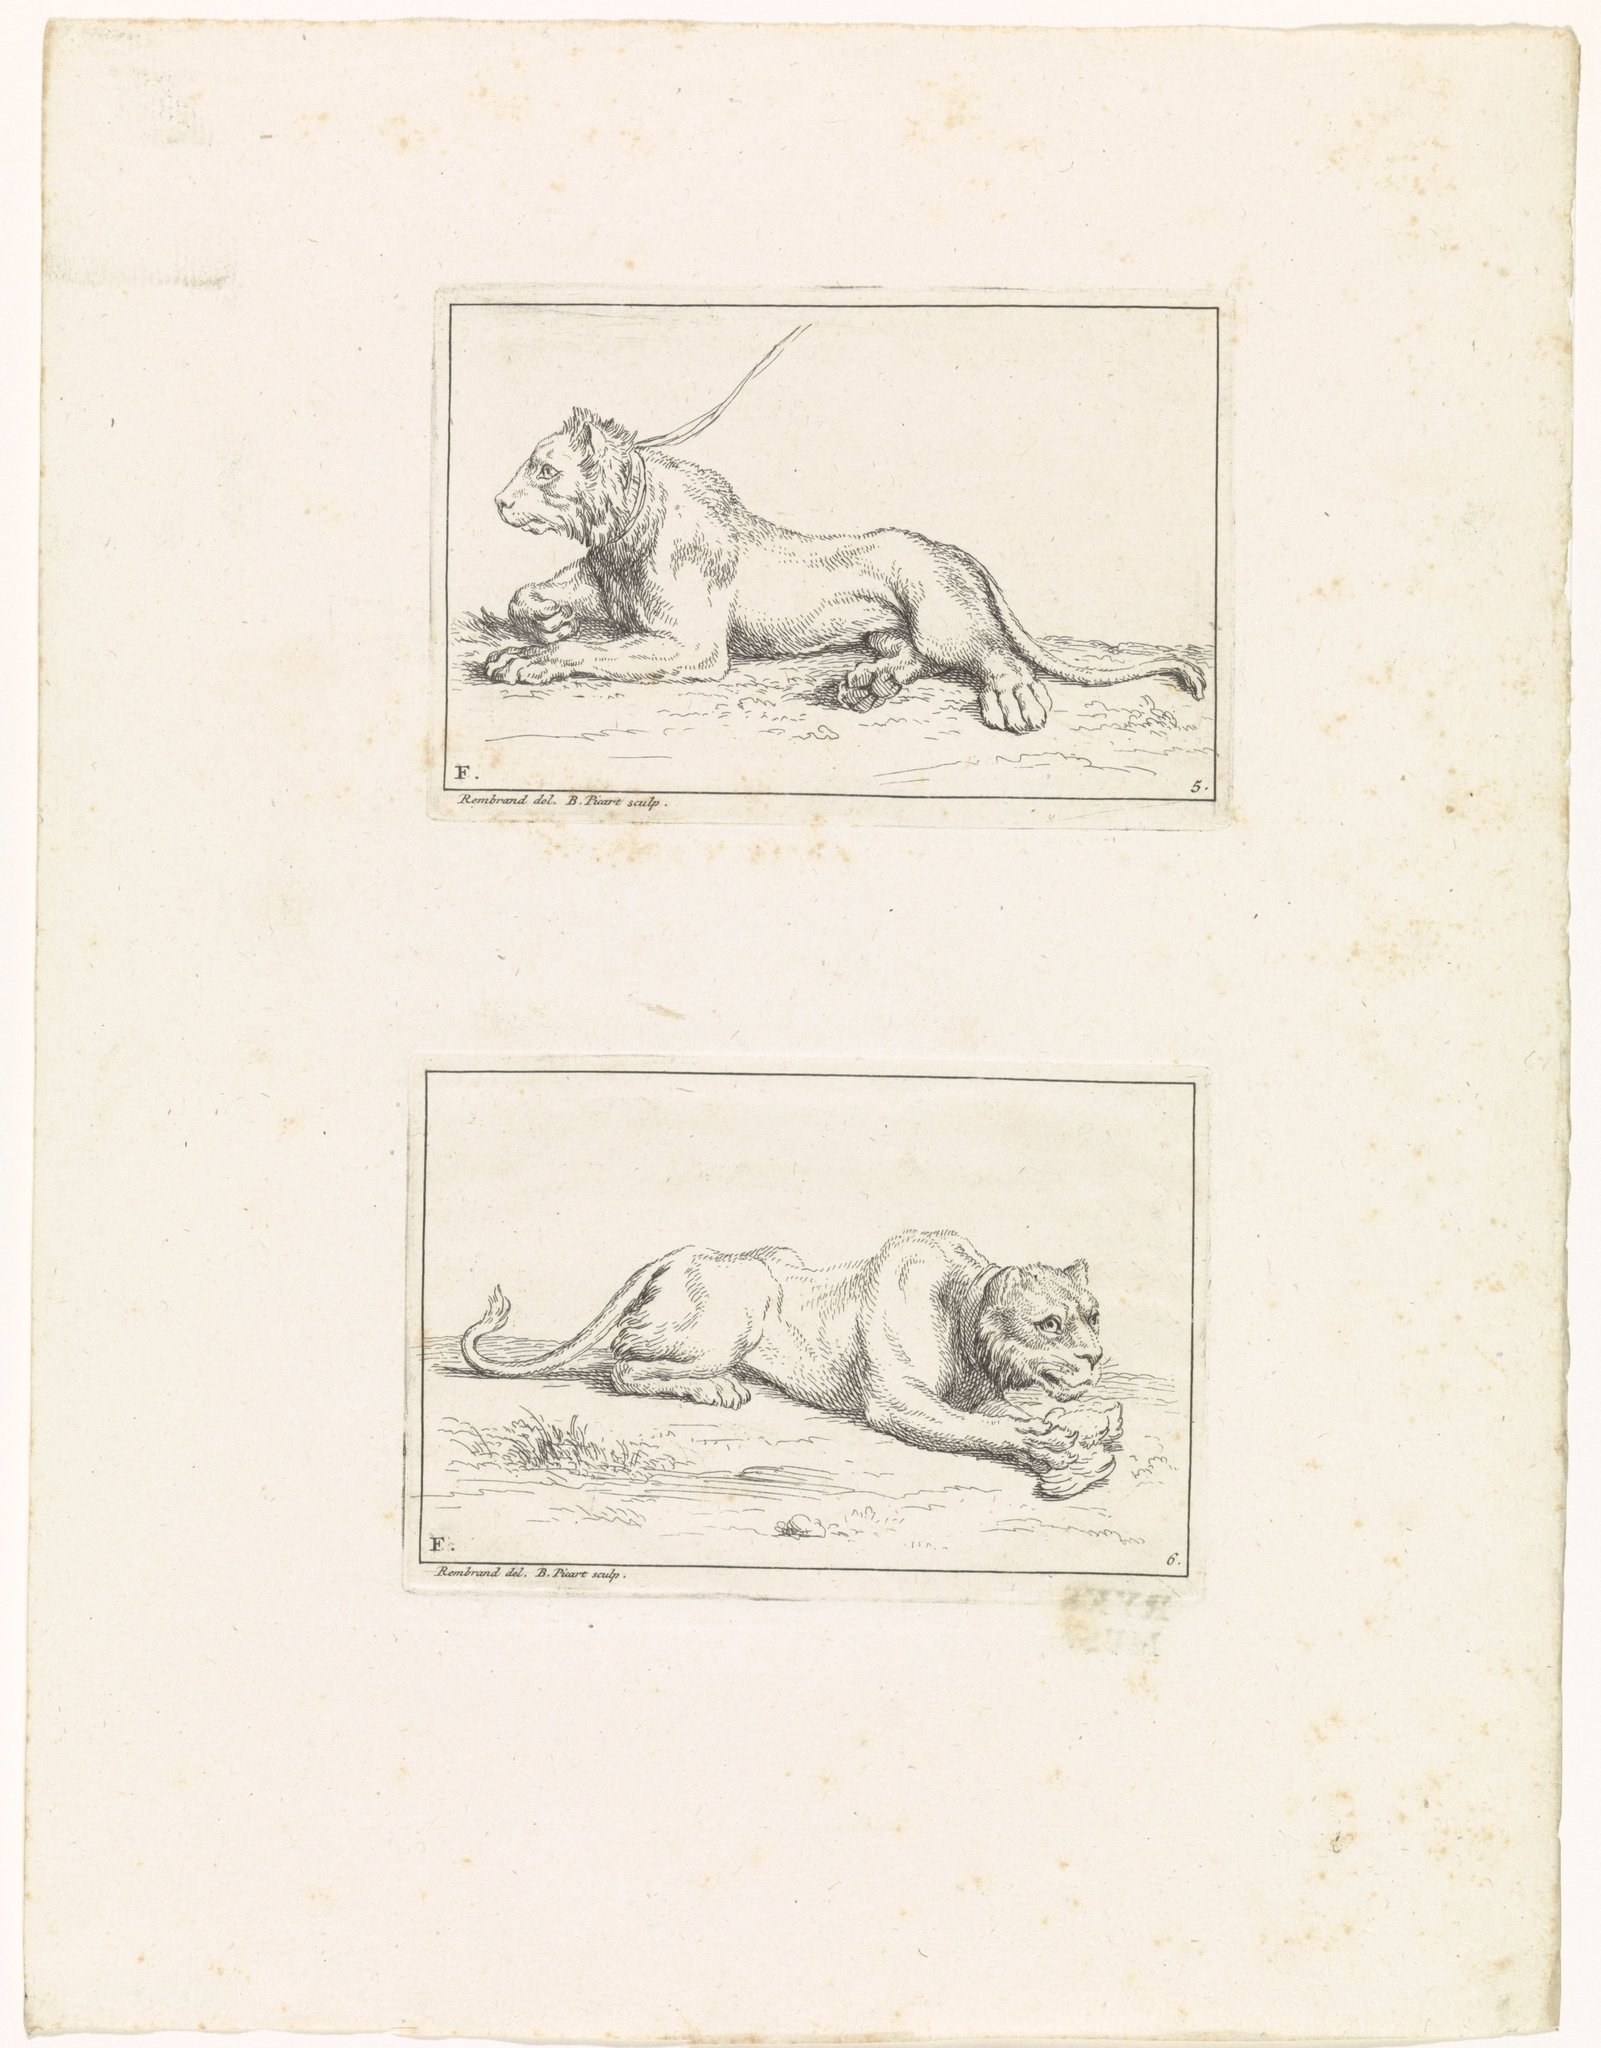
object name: book illustration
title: Twee liggende leeuwen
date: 1728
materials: paper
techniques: etching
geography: amsterdam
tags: beasts of prey, predatory animals: lion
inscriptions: collector's mark: Lugt 2165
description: Twee prenten op één blad. De bovenste prent is gemerkt linksonder: F. Genummerd rechtsonder: 5. De onderste prent is gemerkt linksonder: F. Genummerd rechtsonder: 6.